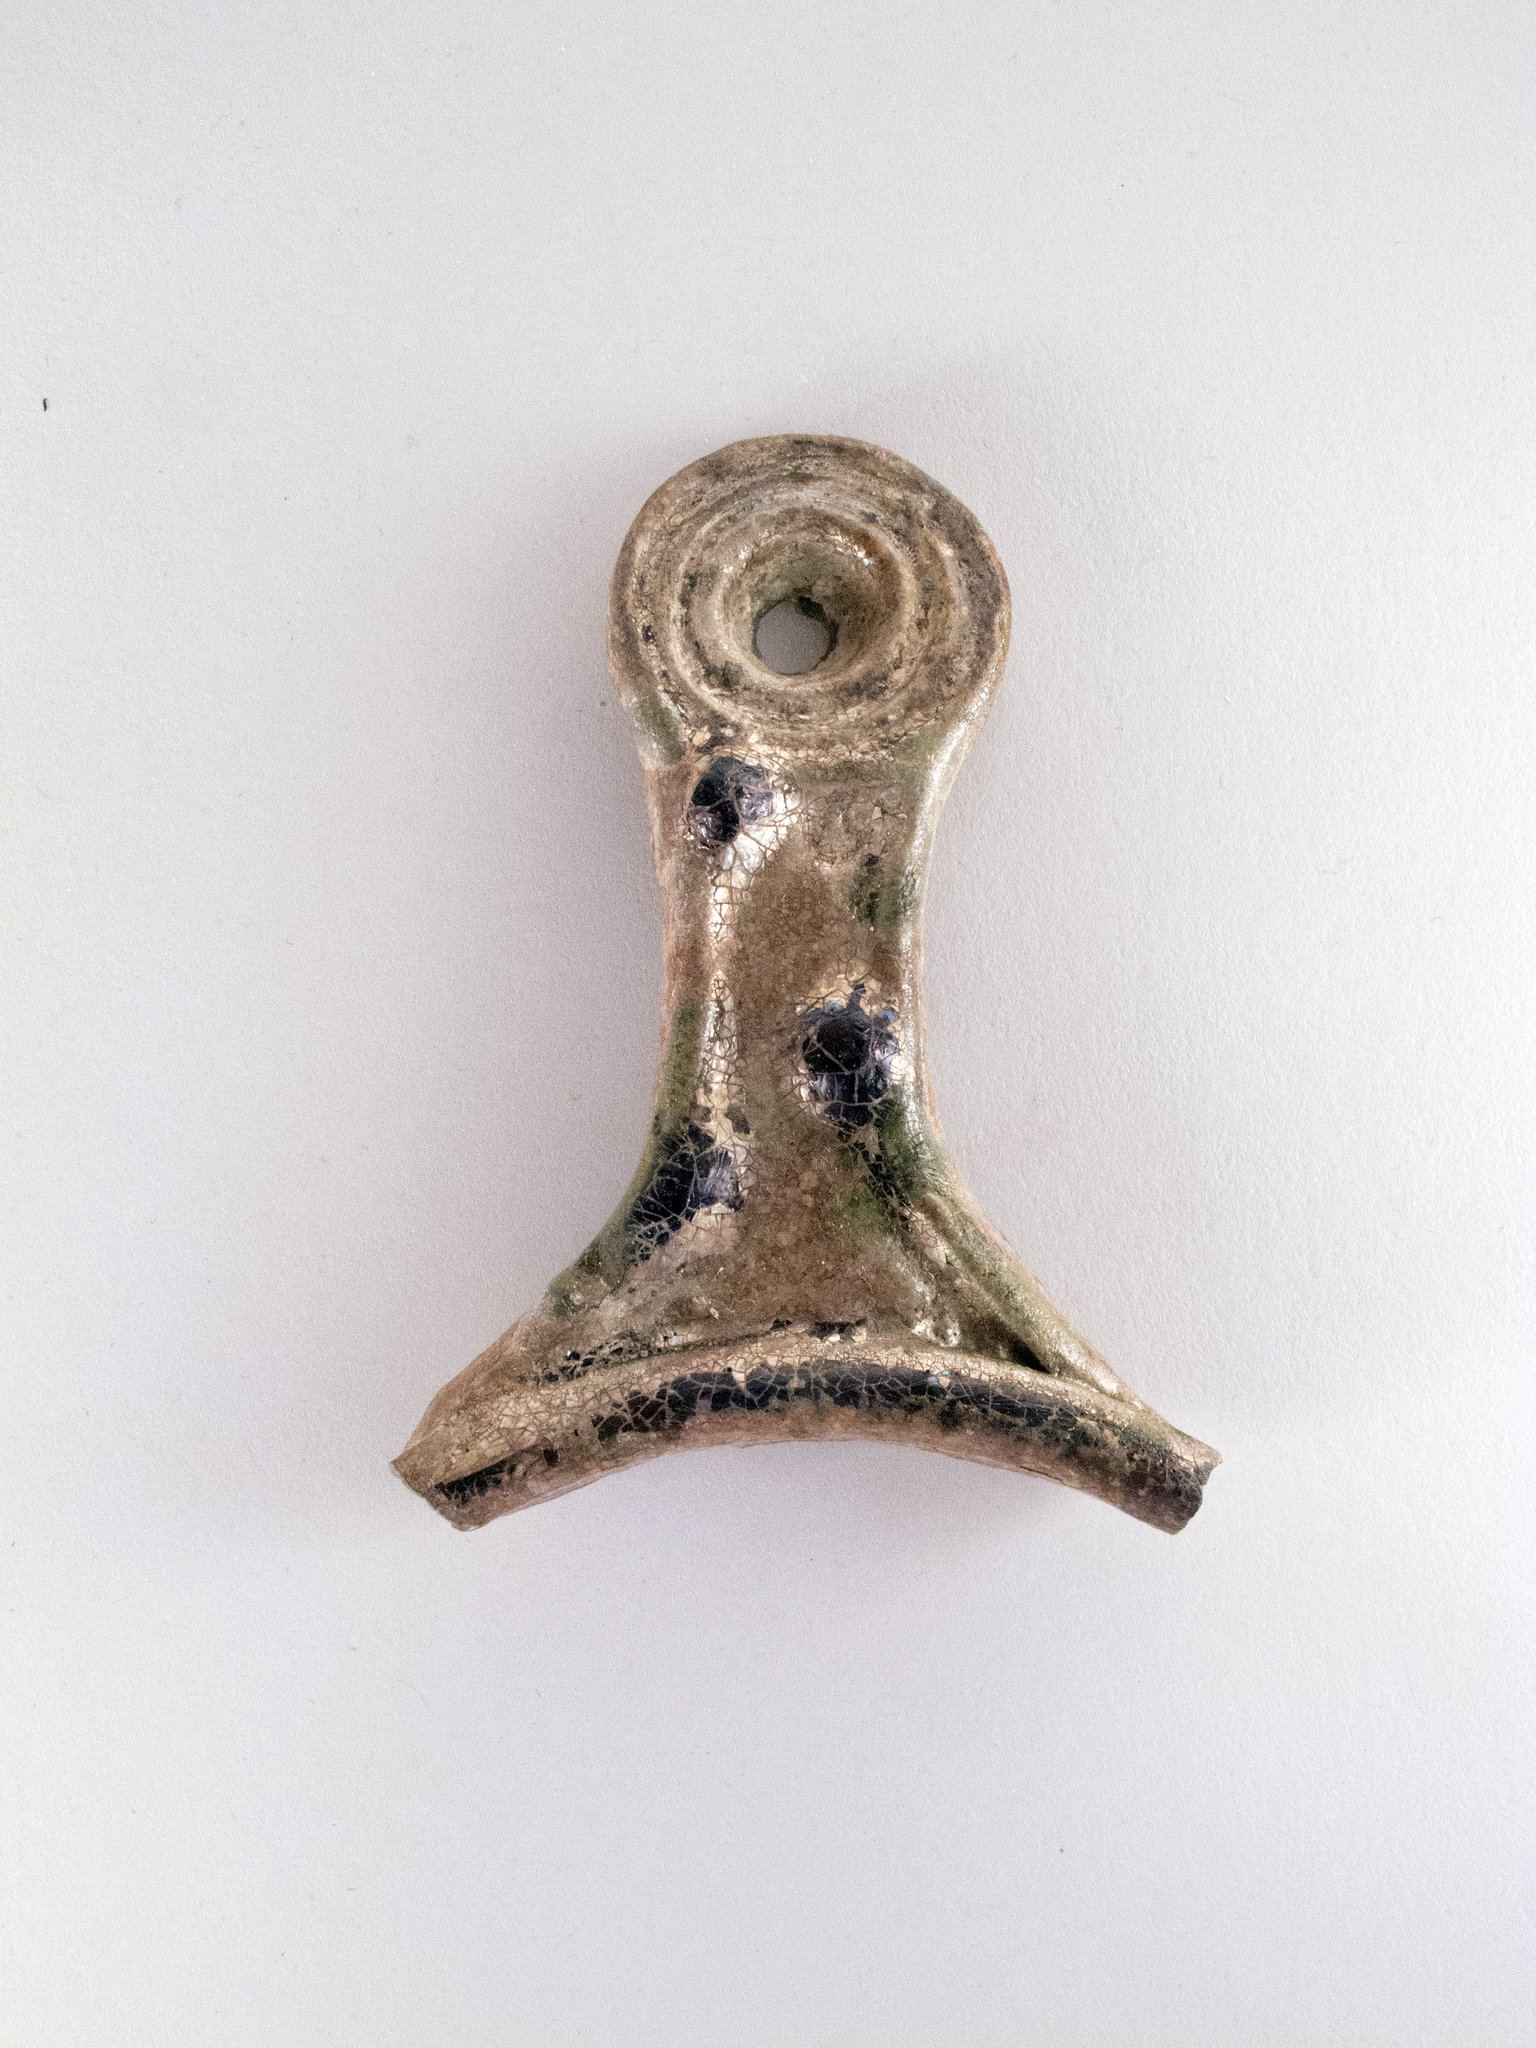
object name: vase fragment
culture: roman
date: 670 BCE-330 CE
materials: terracotta